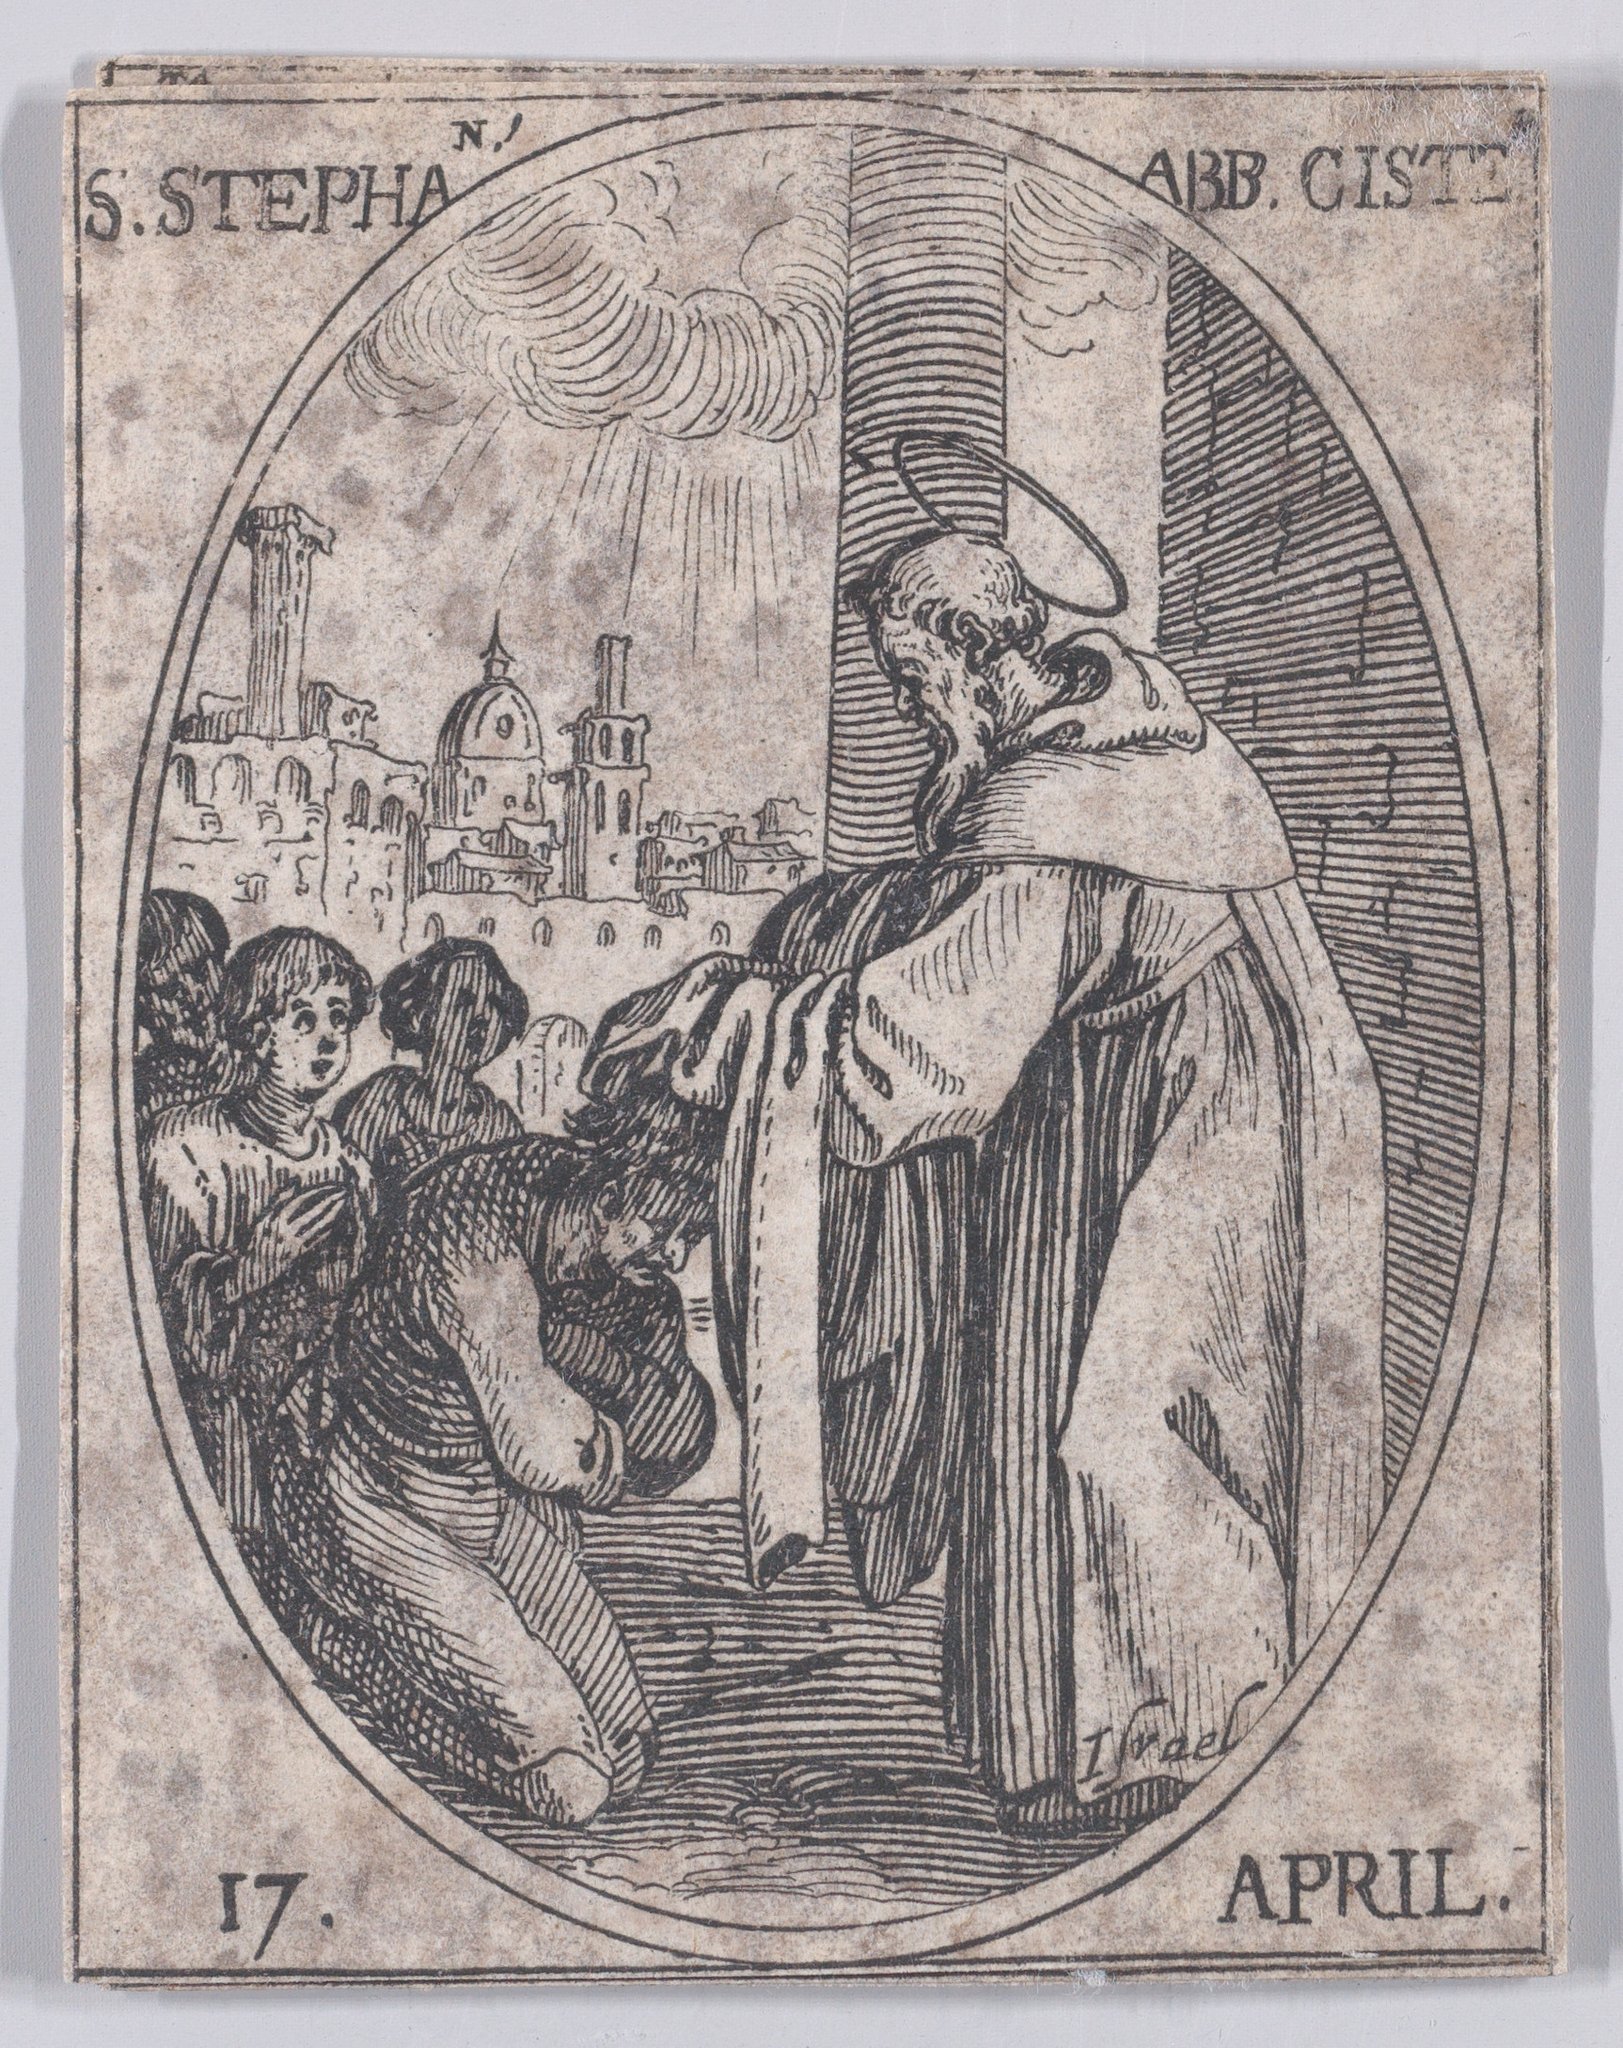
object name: print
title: S. Etienne, abbé de Citeaux (St. Stephen, Abbot of Citeaux), April 17th, from "Les Images De Tous Les Saincts et Saintes de L'Année" (Images of All of the Saints and Religious Events of the Year)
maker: jacques callot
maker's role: artist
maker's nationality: french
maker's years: 1592-1635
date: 1636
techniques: etching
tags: men,saints